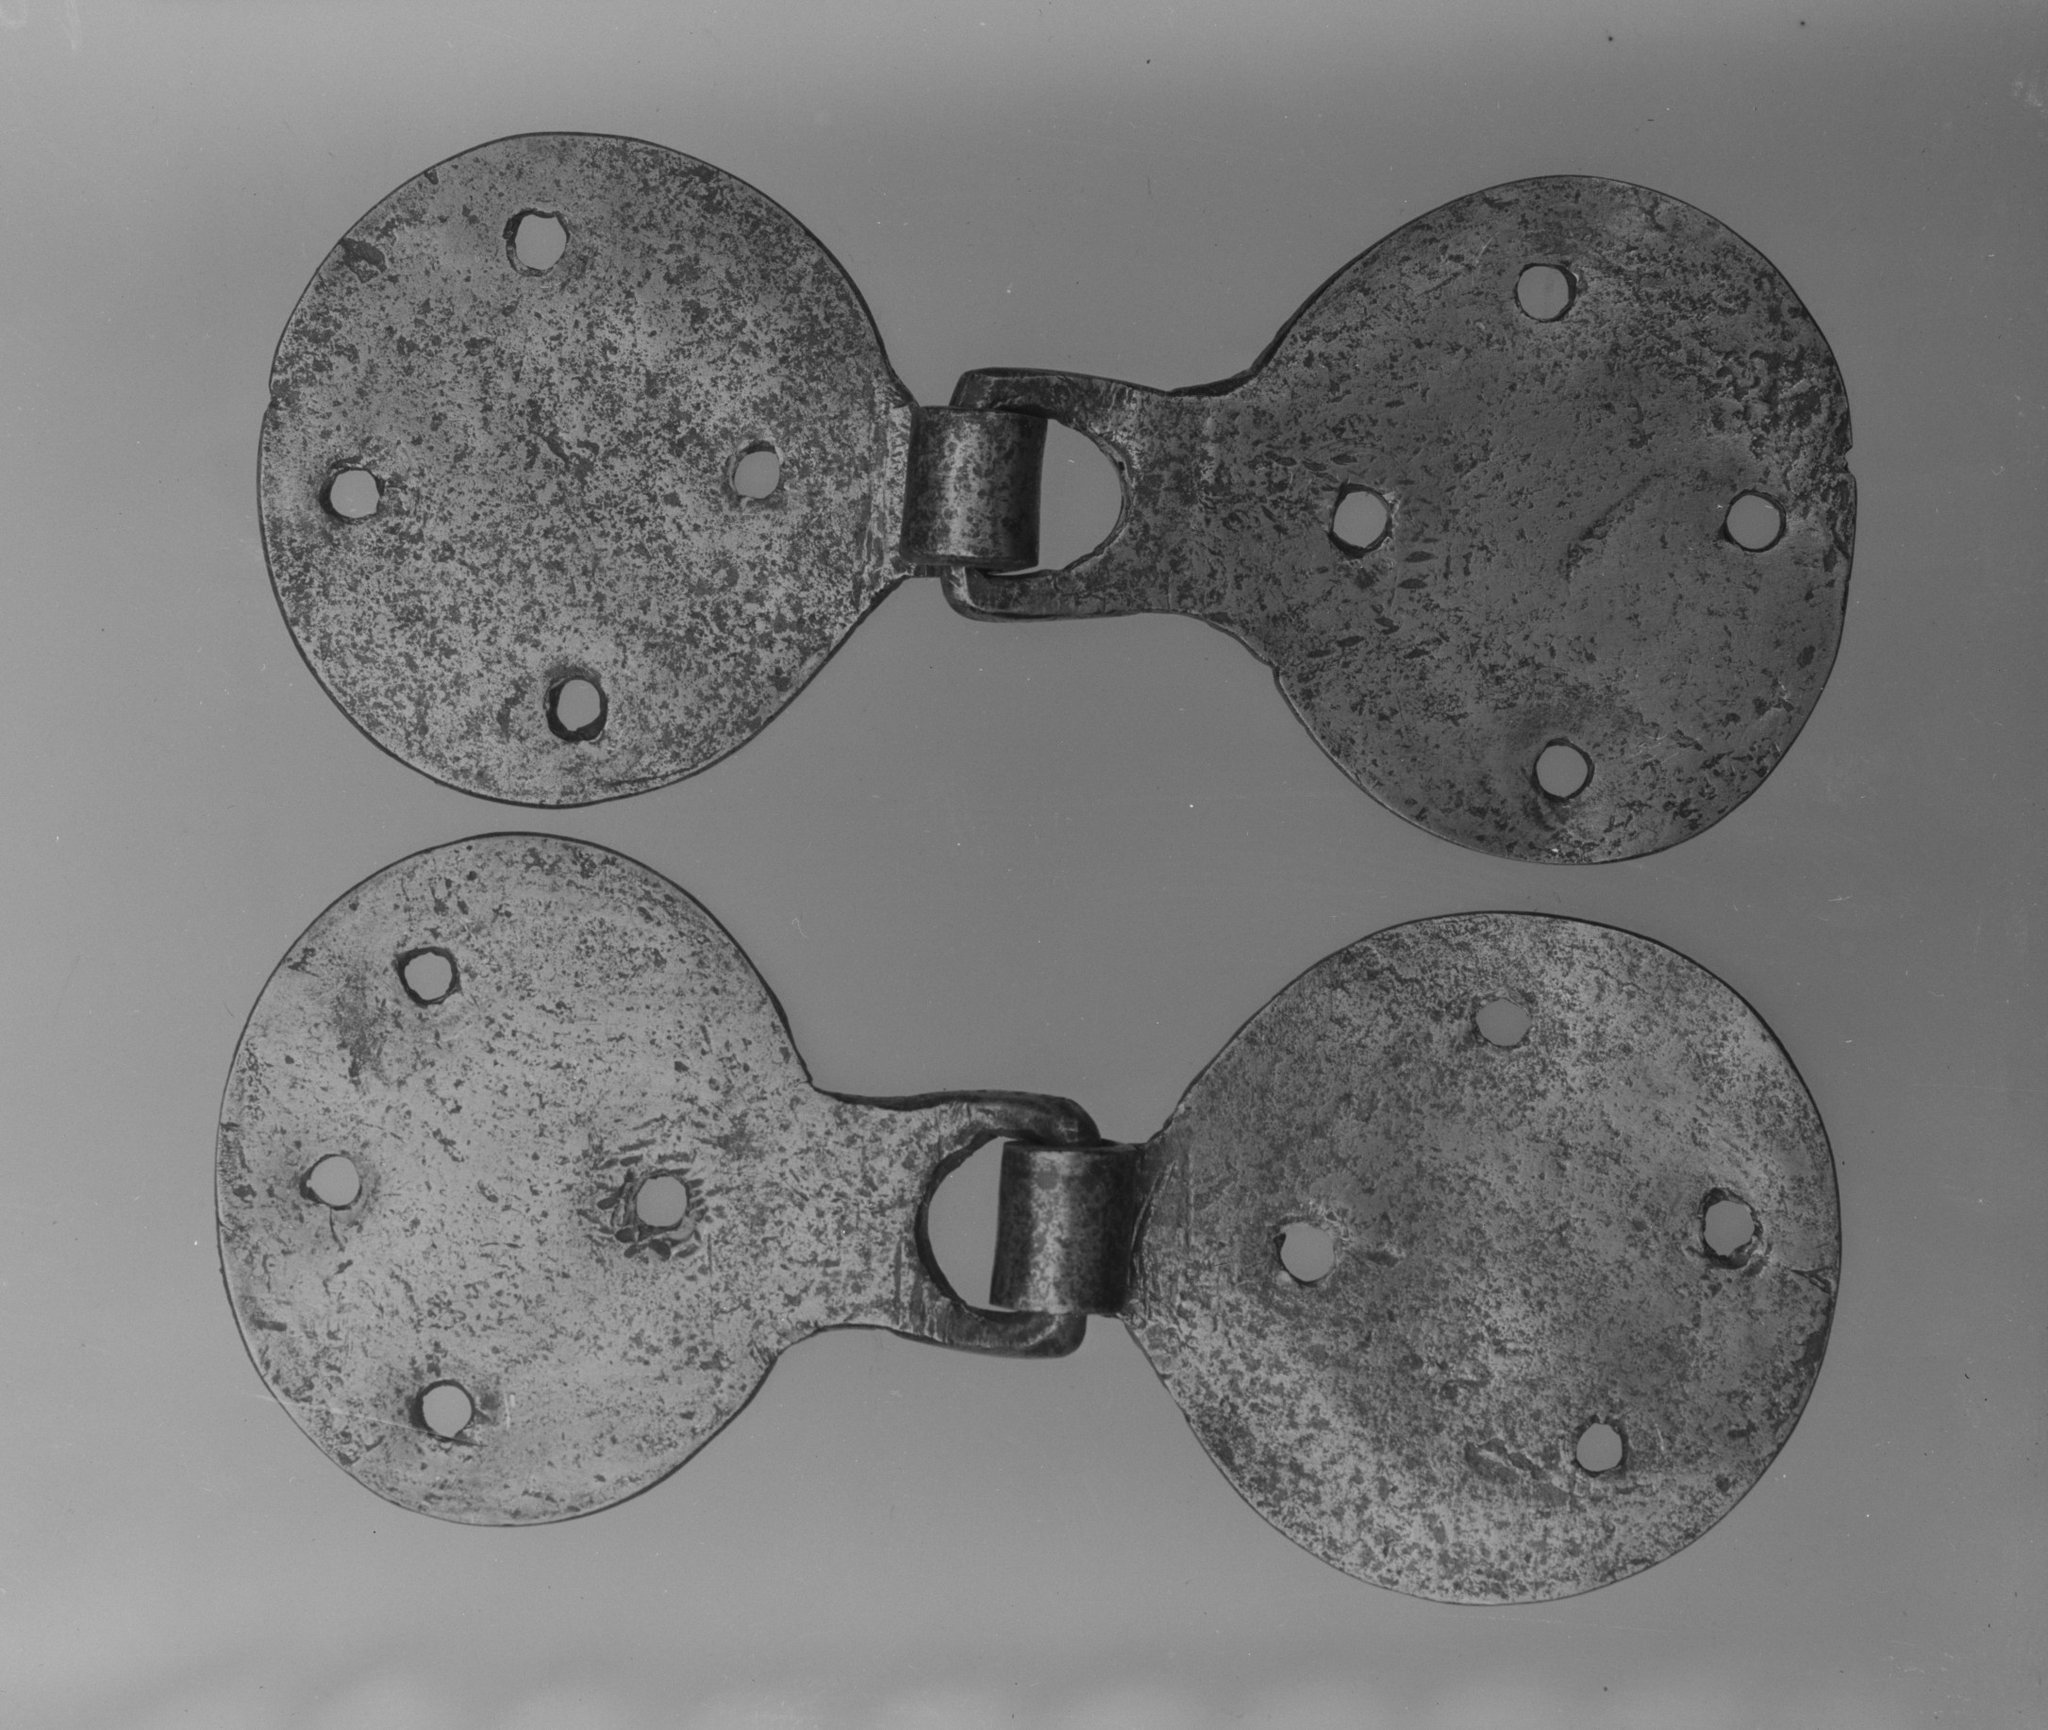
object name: hinge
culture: american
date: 1700-1730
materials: iron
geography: united states